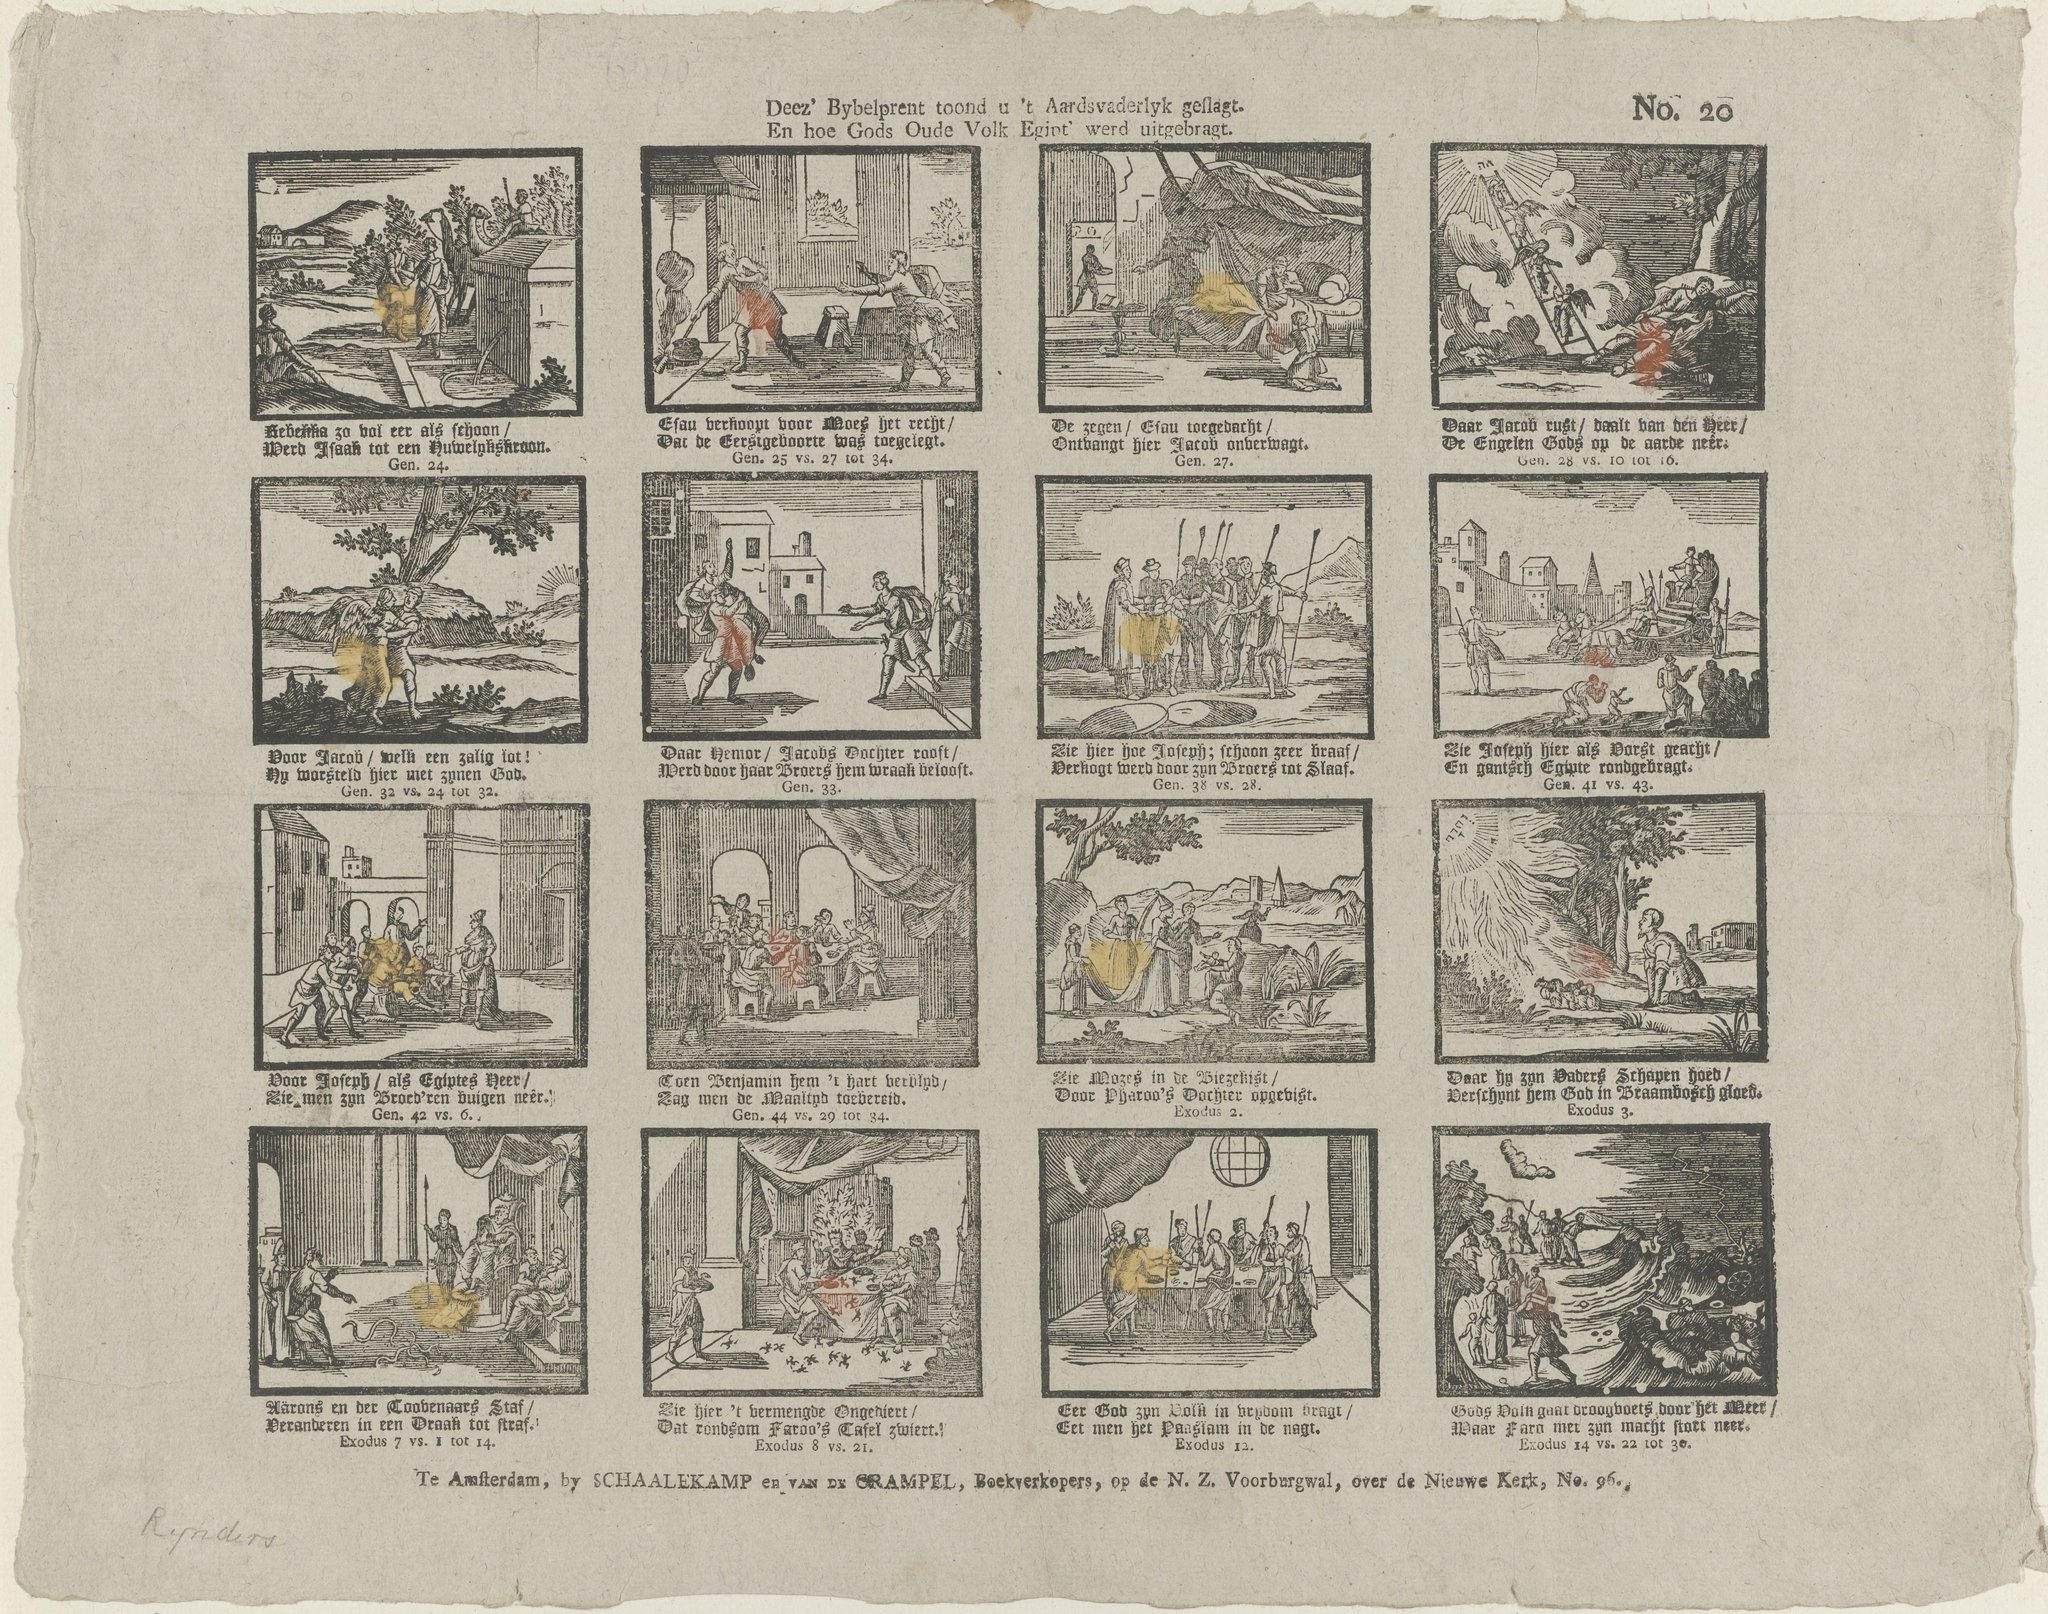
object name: print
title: Deez' bybelprent toond u 't aardsvaderlyk geslagt / En hoe Gods oude volk Egijpt' werd uitgebragt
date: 1795-1819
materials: paper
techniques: colour, letterpress printing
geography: netherlands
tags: moses is pulled out of the water by the servants, old testament, the dream of jacob: while sleeping on the ground with a stone for pillow jacob sees a ladder reaching from earth to heaven with angels going up and down; usually with god at the top of the ladder, passage through the red sea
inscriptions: collector's mark: Lugt 2228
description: Blad met 16 voorstellingen van verhalen uit het Oude Testament, waaronder Jakobs droom, Mozes die wordt gevonden en de doortocht door de Rode zee. Onder elke voorstelling een tweeregelig vers en een verwijzing naar de bijbehorende Bijbeltekst. Genummerd rechtsboven: No. 20.